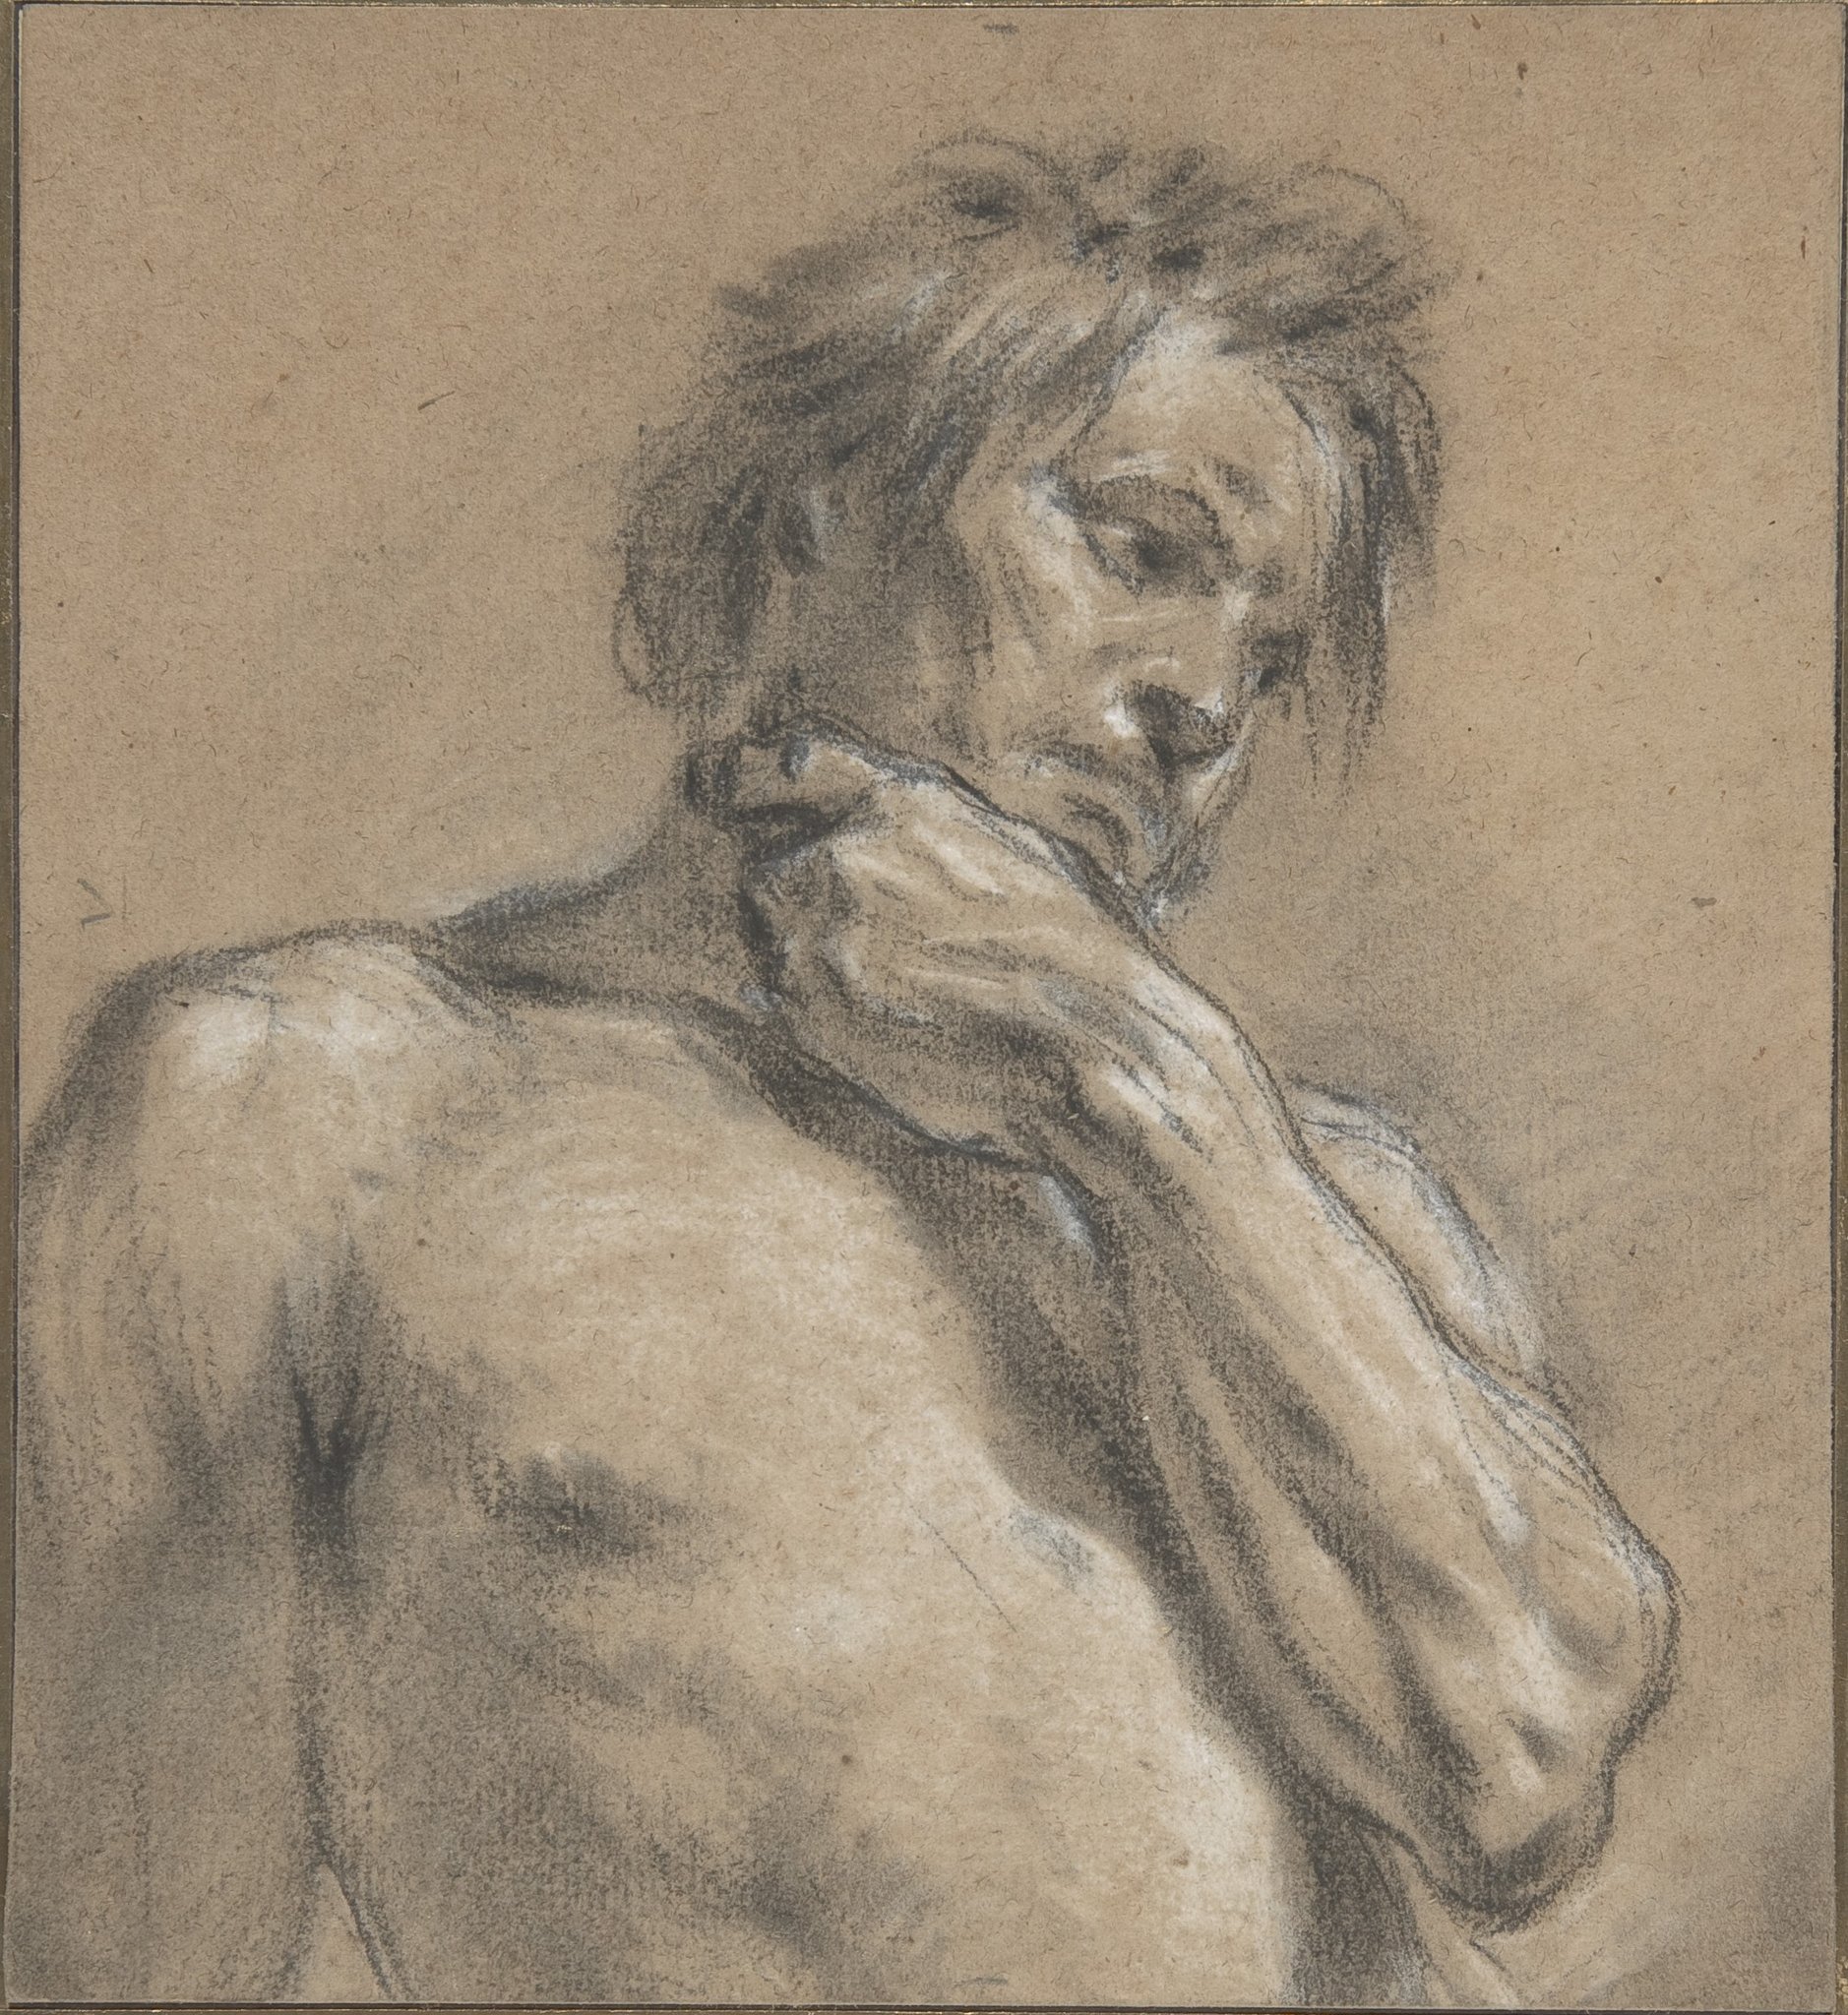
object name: drawing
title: Half-Length Study of a Man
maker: françois boucher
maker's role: artist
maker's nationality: french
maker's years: 1703-1770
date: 1701-1800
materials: chalk, paper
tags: contemplation,men